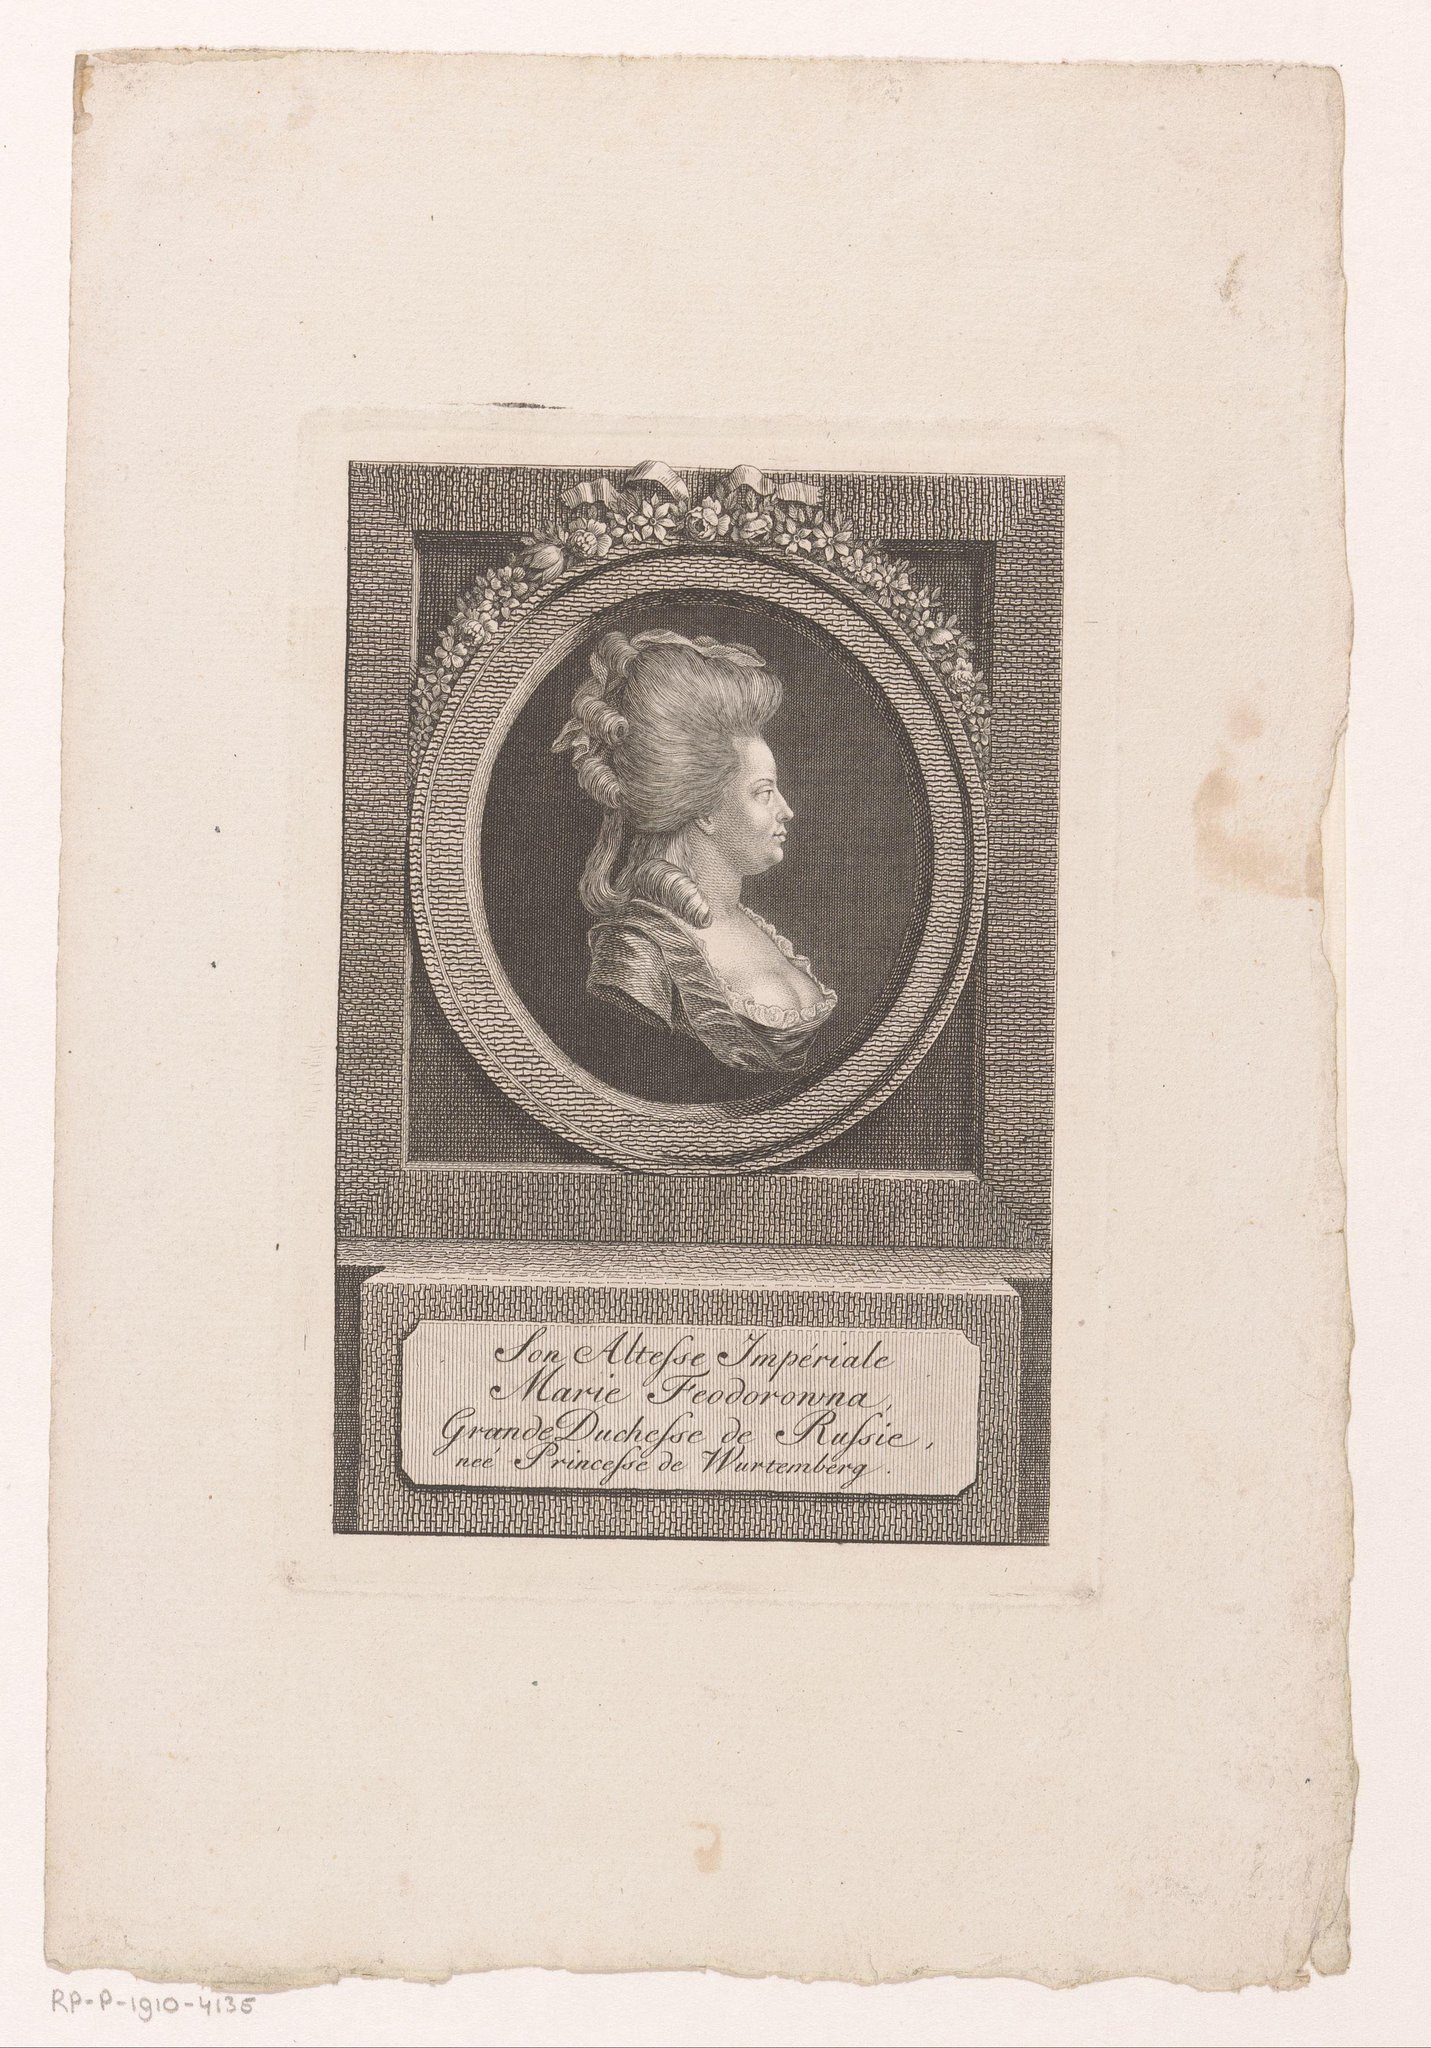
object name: print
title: Portret van Sophia Dorothea Augusta Louisa van Württemberg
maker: johann ernst mansfeld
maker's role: print maker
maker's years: 1739-1796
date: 1749-1796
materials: paper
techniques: engraving, etching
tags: poland, maria féodorowna, historical persons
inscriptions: collector's mark: Lugt 2228